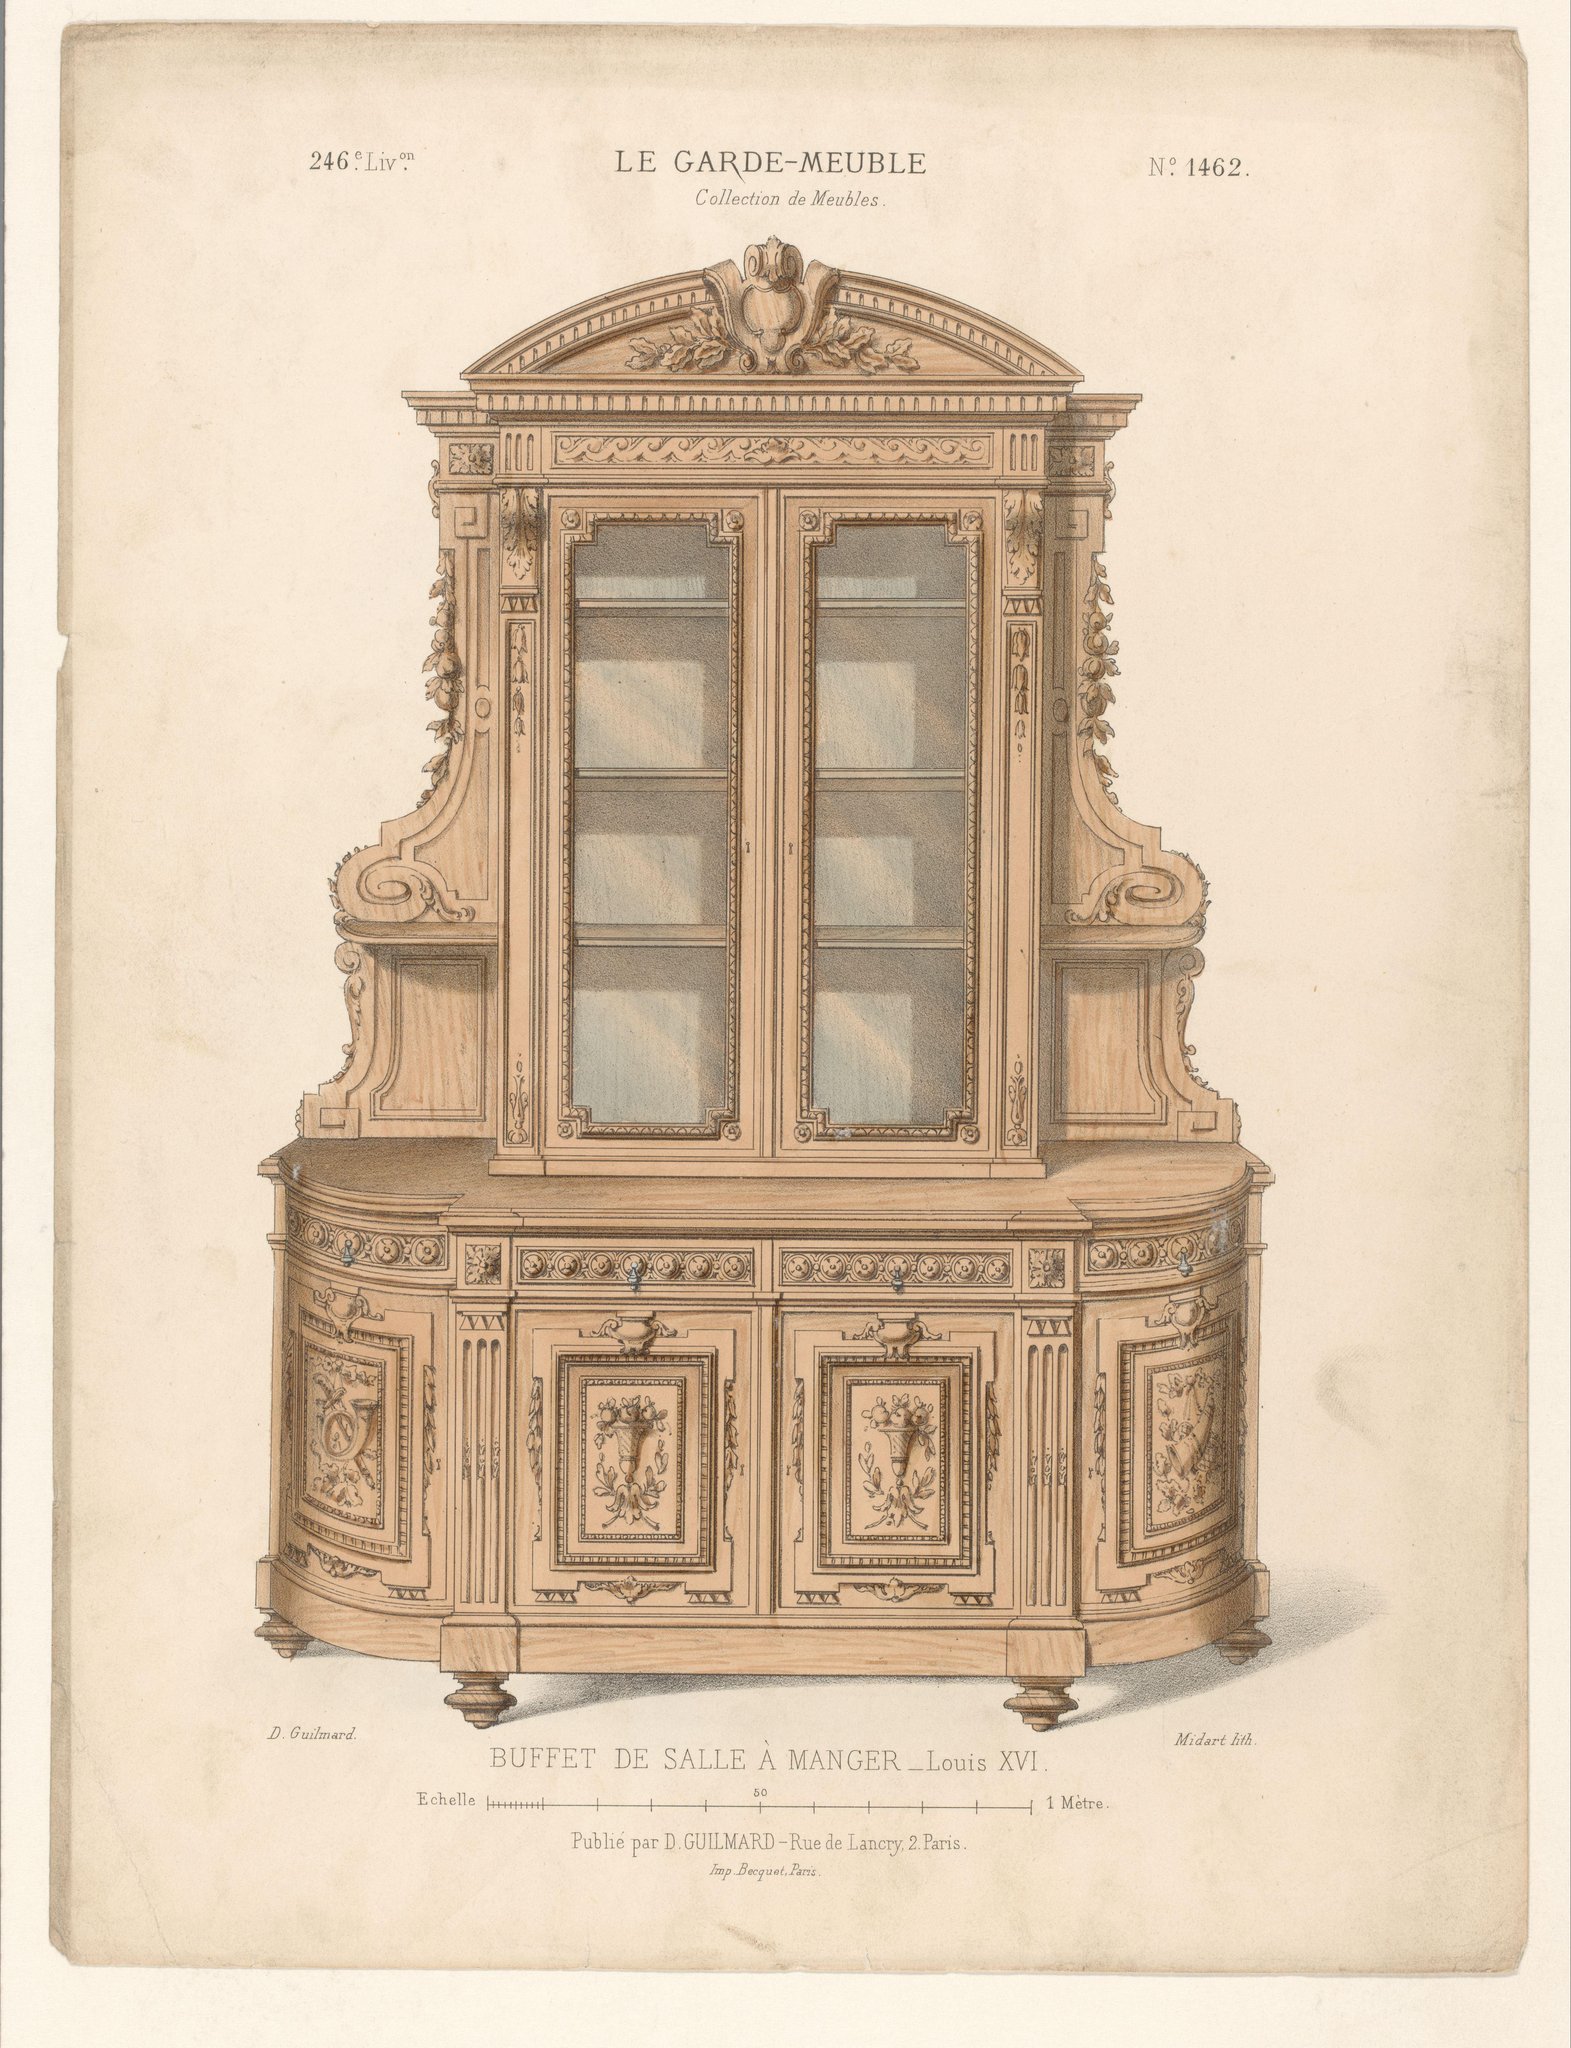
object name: print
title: Buffetkast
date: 1839-1885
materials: paper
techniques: hand coloring, lithograph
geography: paris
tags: furniture for storage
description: Ieder Livraison in de serie Le Garde-Meuble bevat negen platen: drie 'sièges' (zitmeubels), drie 'meubles' (diverse meubels zoals tafels en kasten) en drie 'tentures' (gordijnen en draperieën).